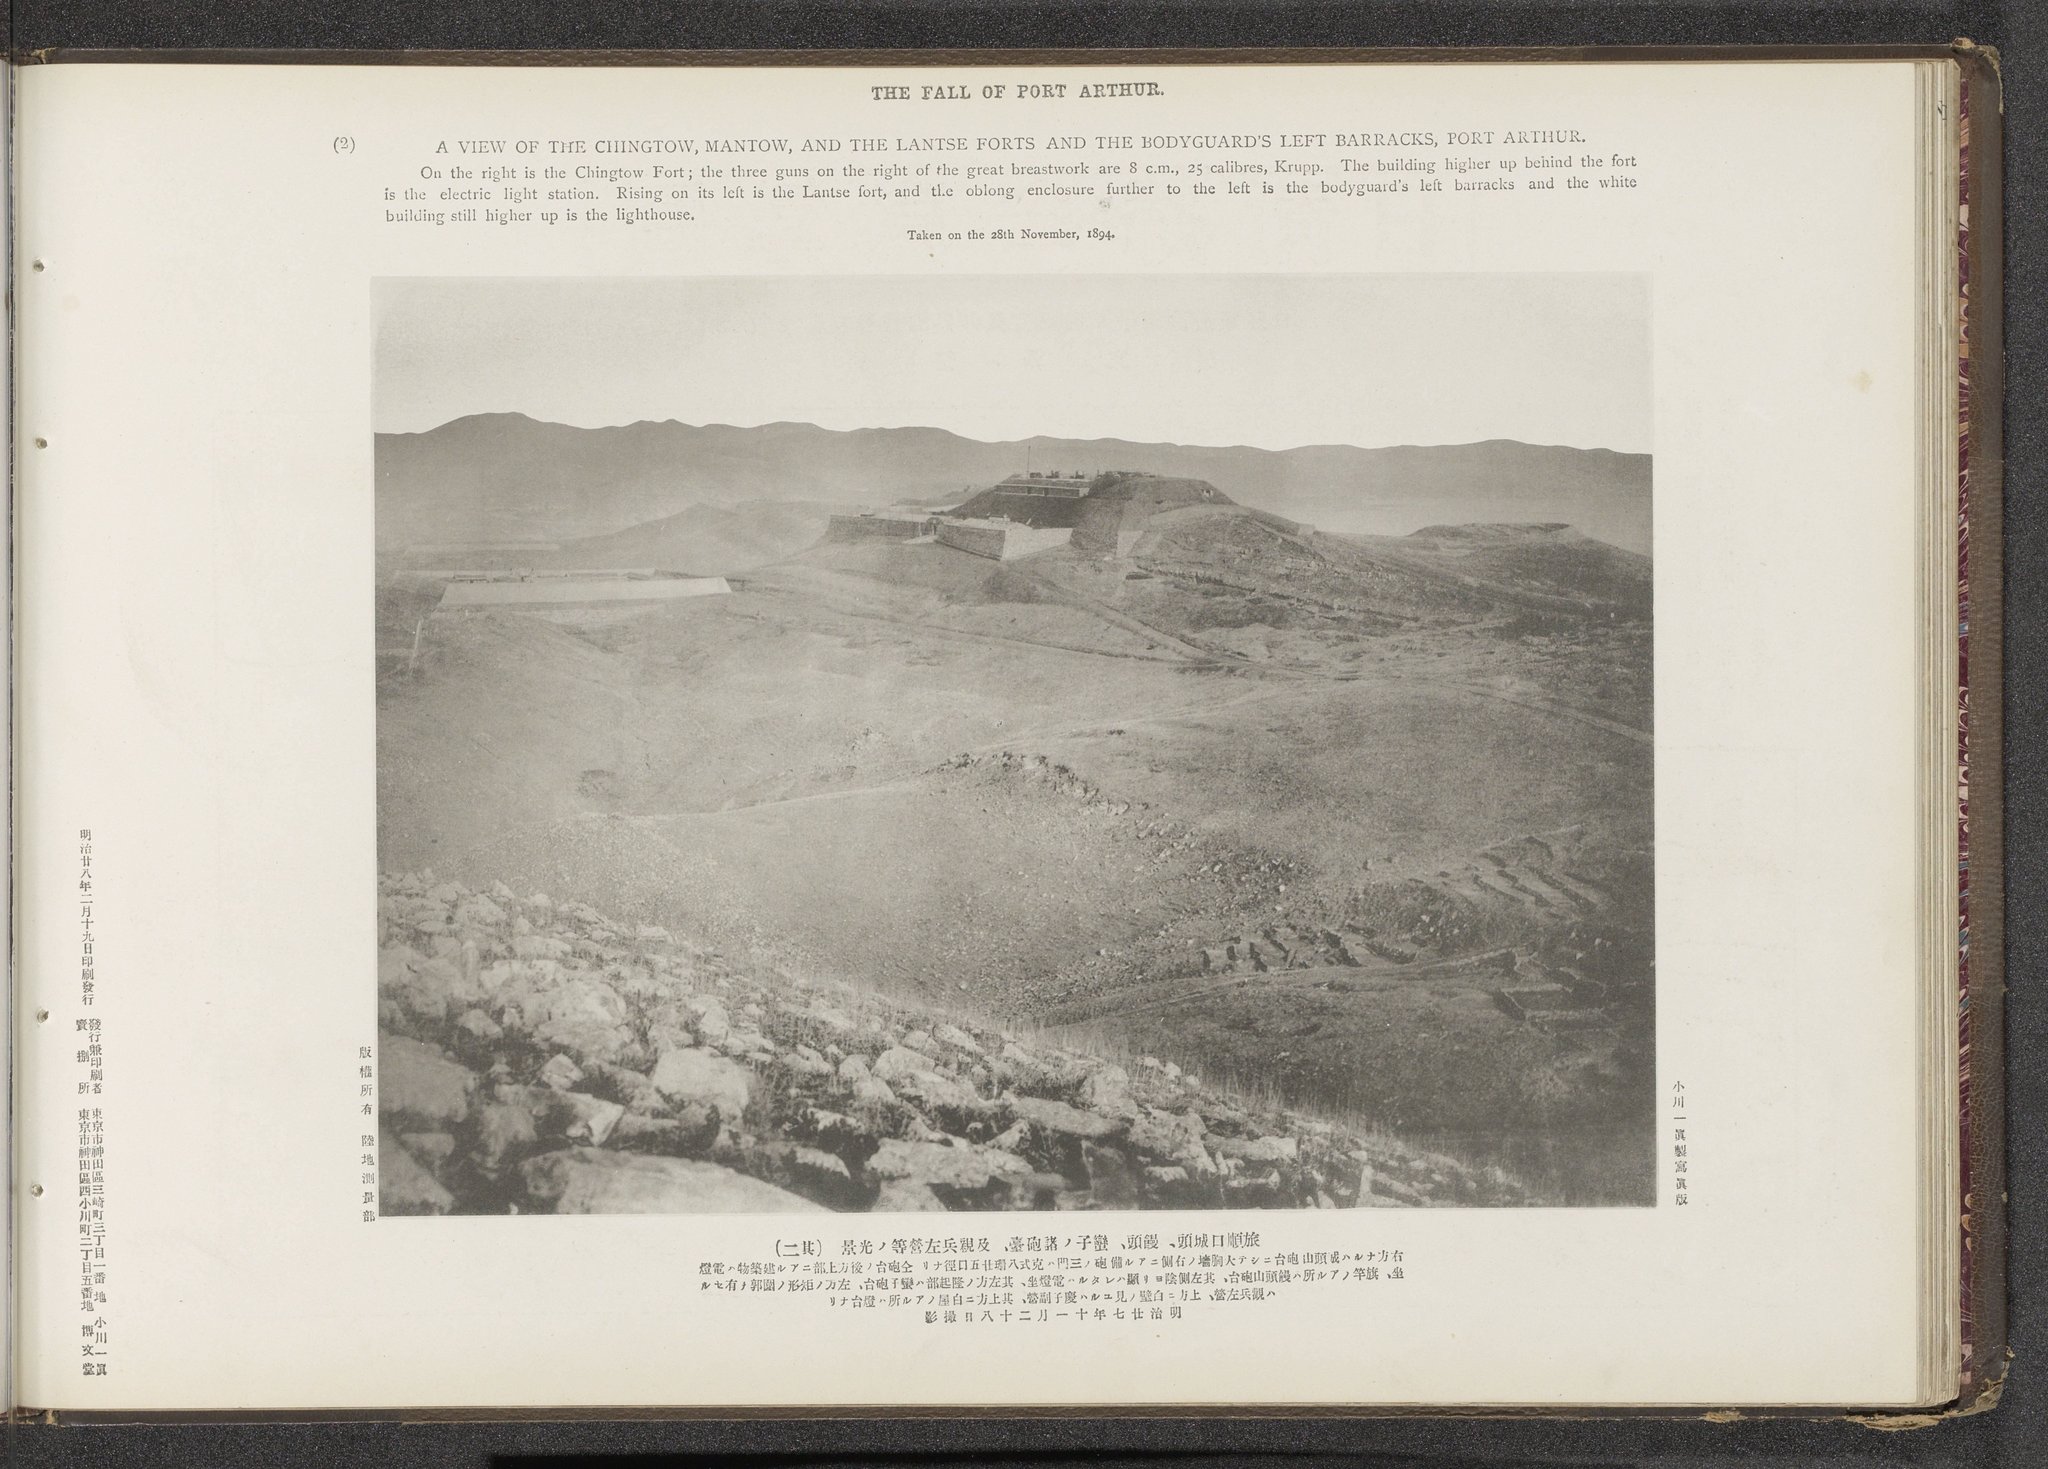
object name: photomechanical print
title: A view of the Chingtow, Mantow, and the Lantse forts and the bodyguards left barracks, Port Arthur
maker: kazumasa ogawa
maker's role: auteur, fotograaf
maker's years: 1860-1929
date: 1894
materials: paper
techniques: photograph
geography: japan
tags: fortress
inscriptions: inscription: ‘On the right is the Chingtow Fort (...) the white building still higher up is the lighthouse.’, inscription: ‘The fall of Port Arthur.’